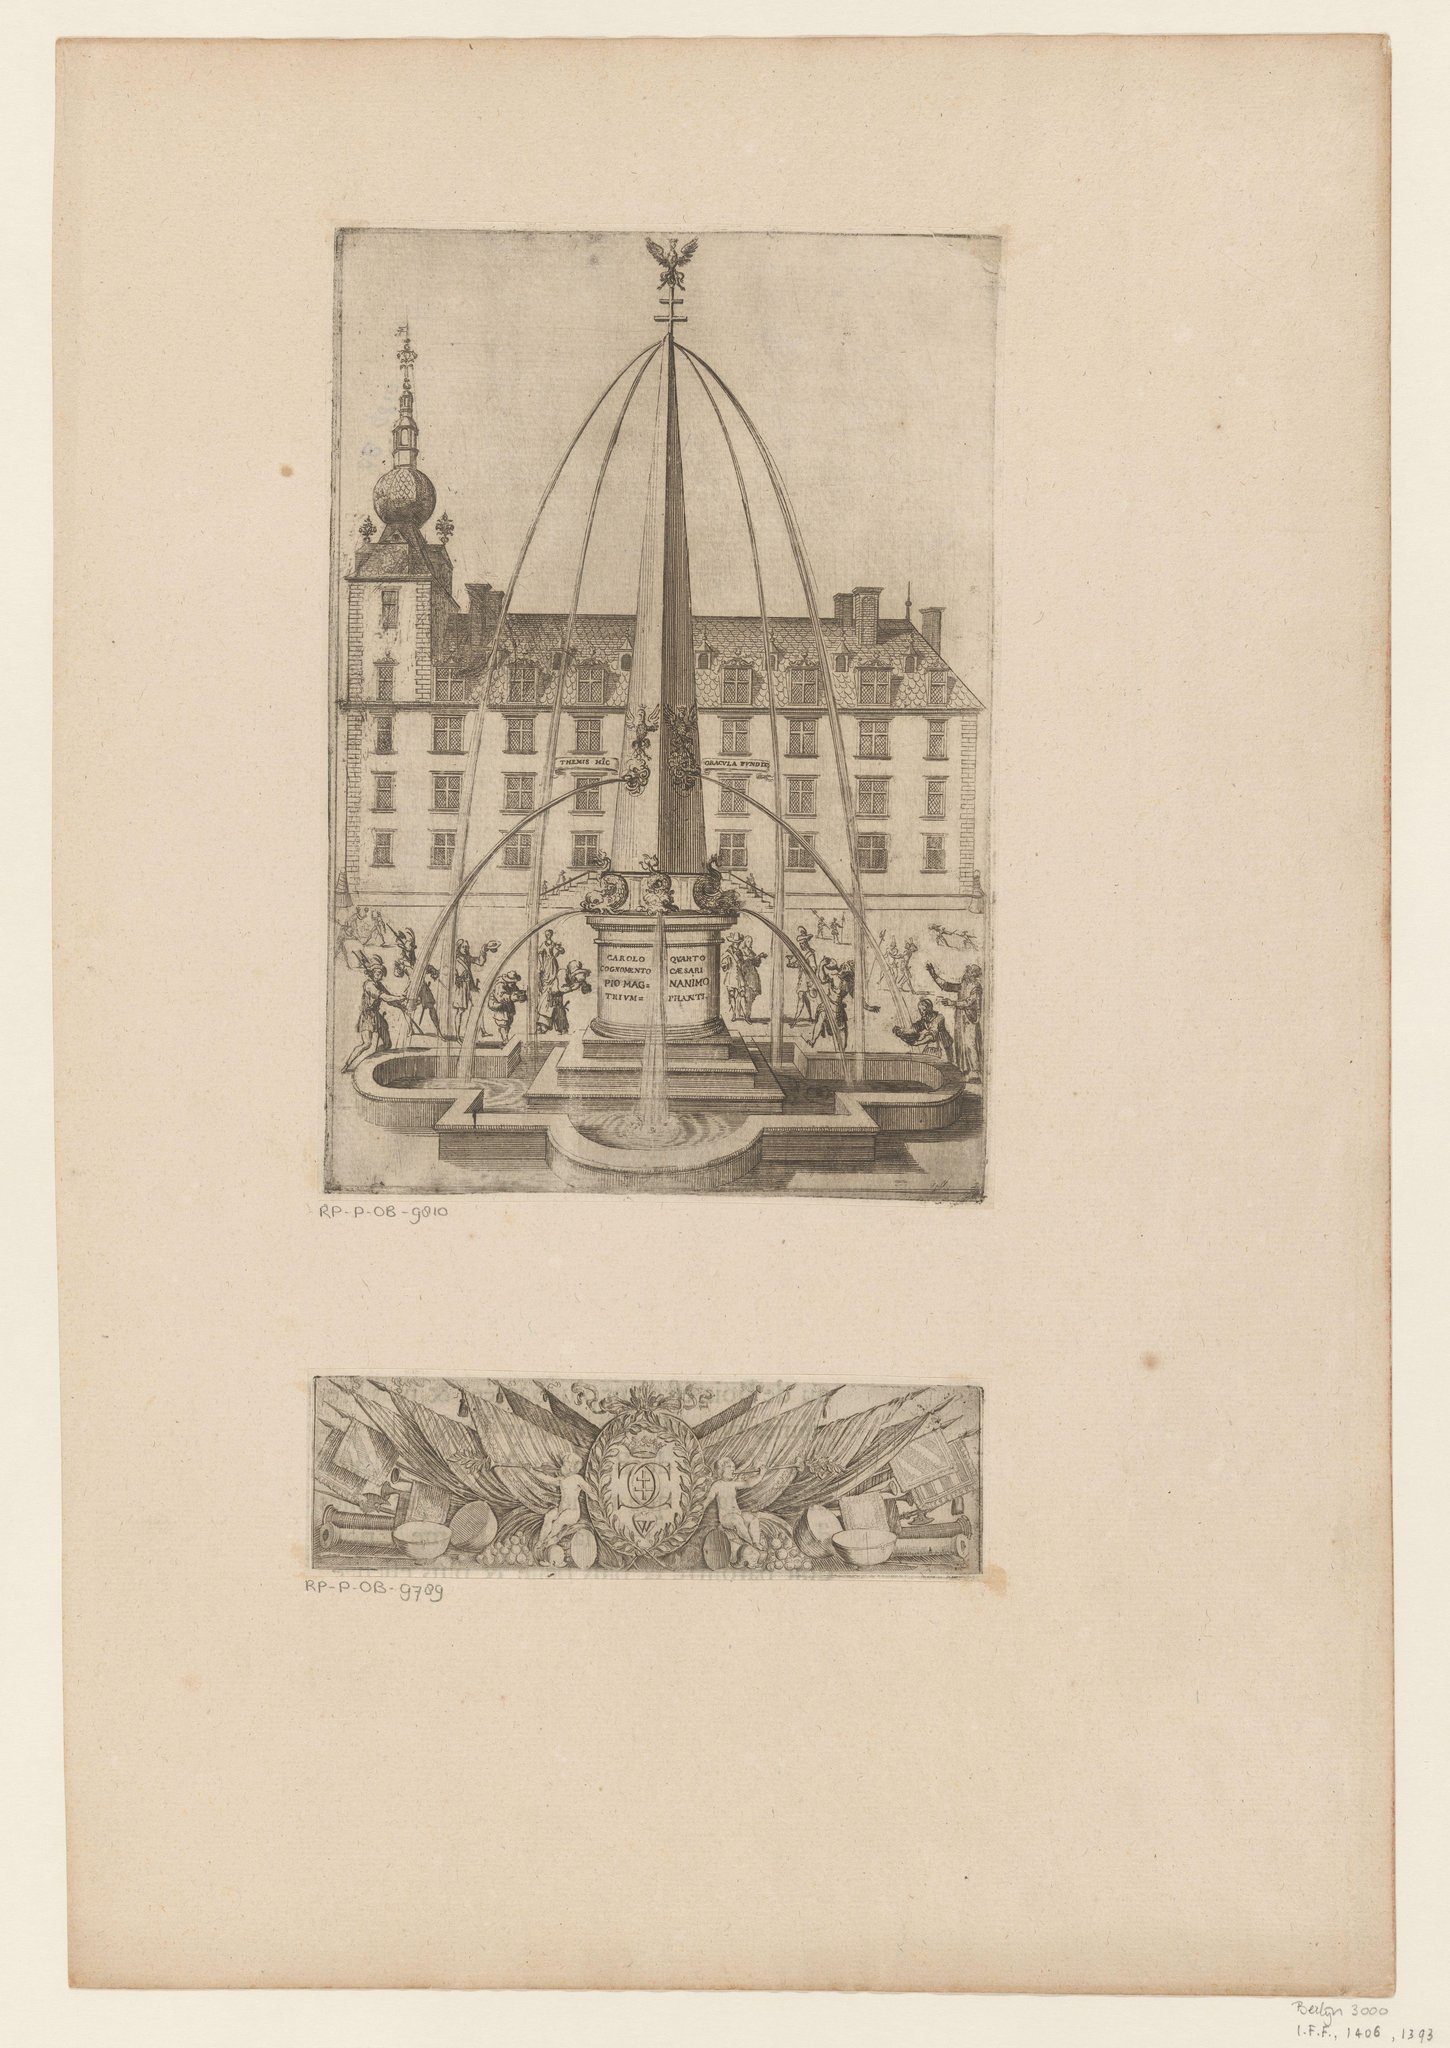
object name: ornament print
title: Monumenten en feestelijkheden tijdens intocht van Karel IV in Nancy, 1641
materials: paper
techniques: etching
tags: karel iv hertog van lotharingen, ornaments ~ art, letter combinations such as letterword, anagram, letter square, monogram, etc.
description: Een fries met een medaillon met het monogram van Karel IV omgeven door een lauwerkrans. Links en rechts vlaggen, wapens en een putto blazend op een bazuin.